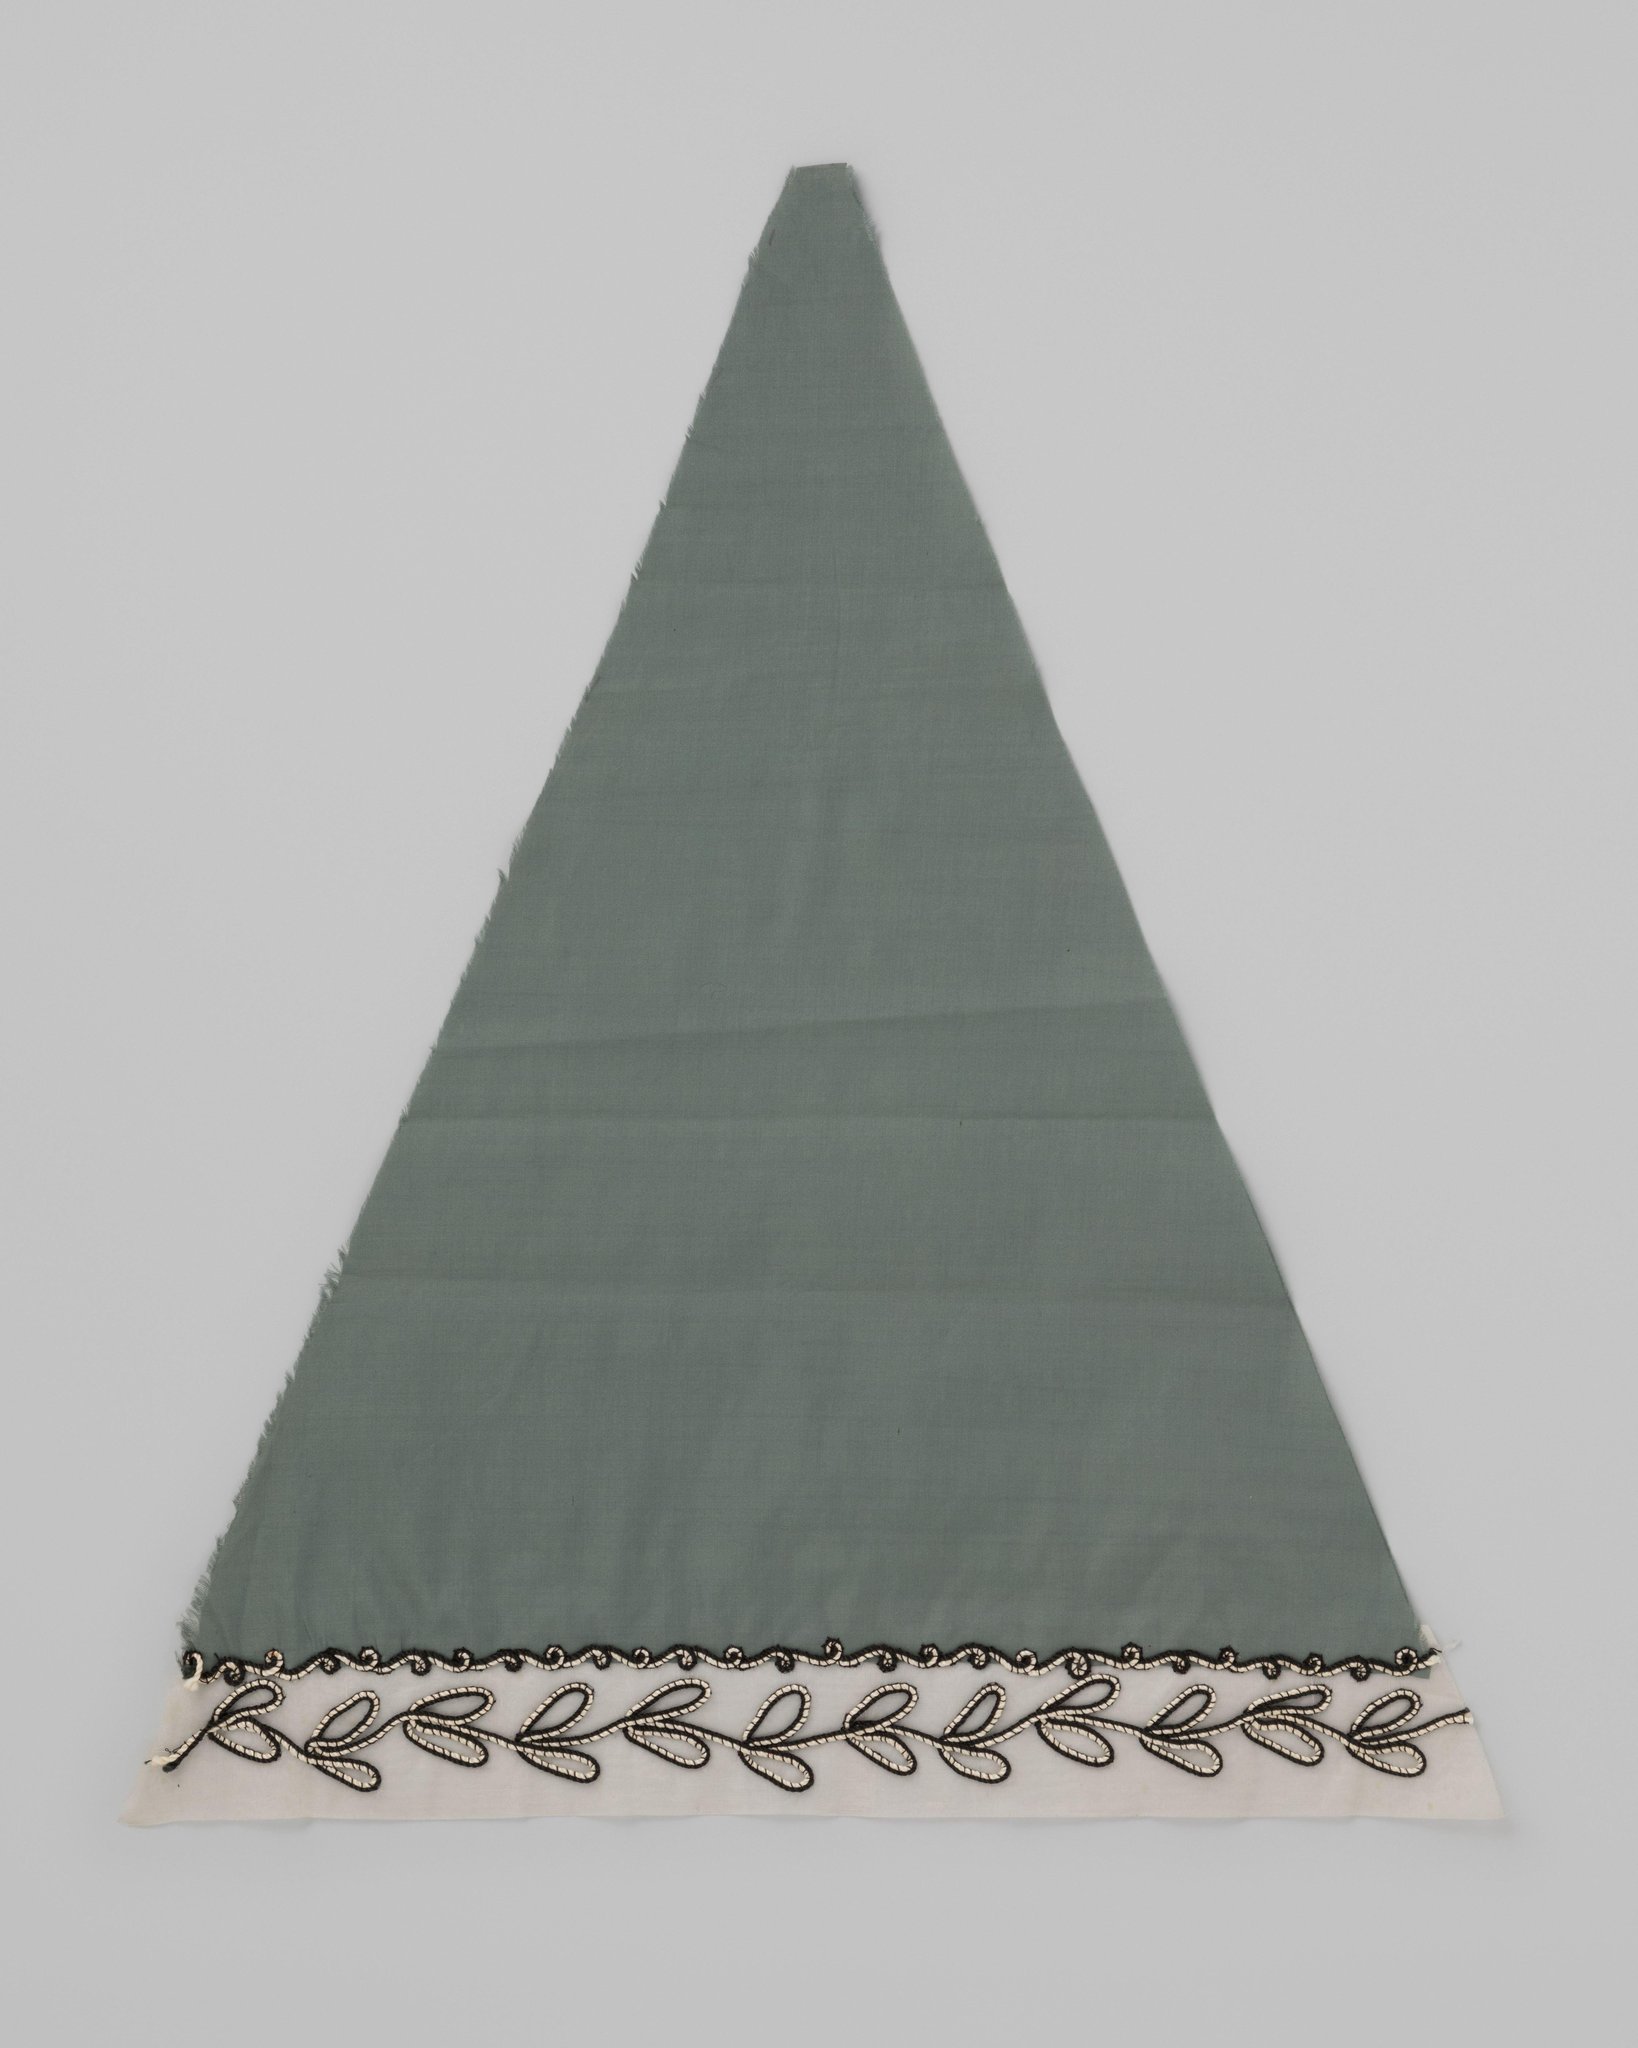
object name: parasoldek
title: Sector van een parasoldek van zachtgroene katoen, met een met woldraad geborduurde batisten rand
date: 1885-1900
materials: cotton, wool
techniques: embroidered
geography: nijmegen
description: Sector van een parasoldek van zachtgroene katoen, met een met woldraad geborduurde batisten rand.